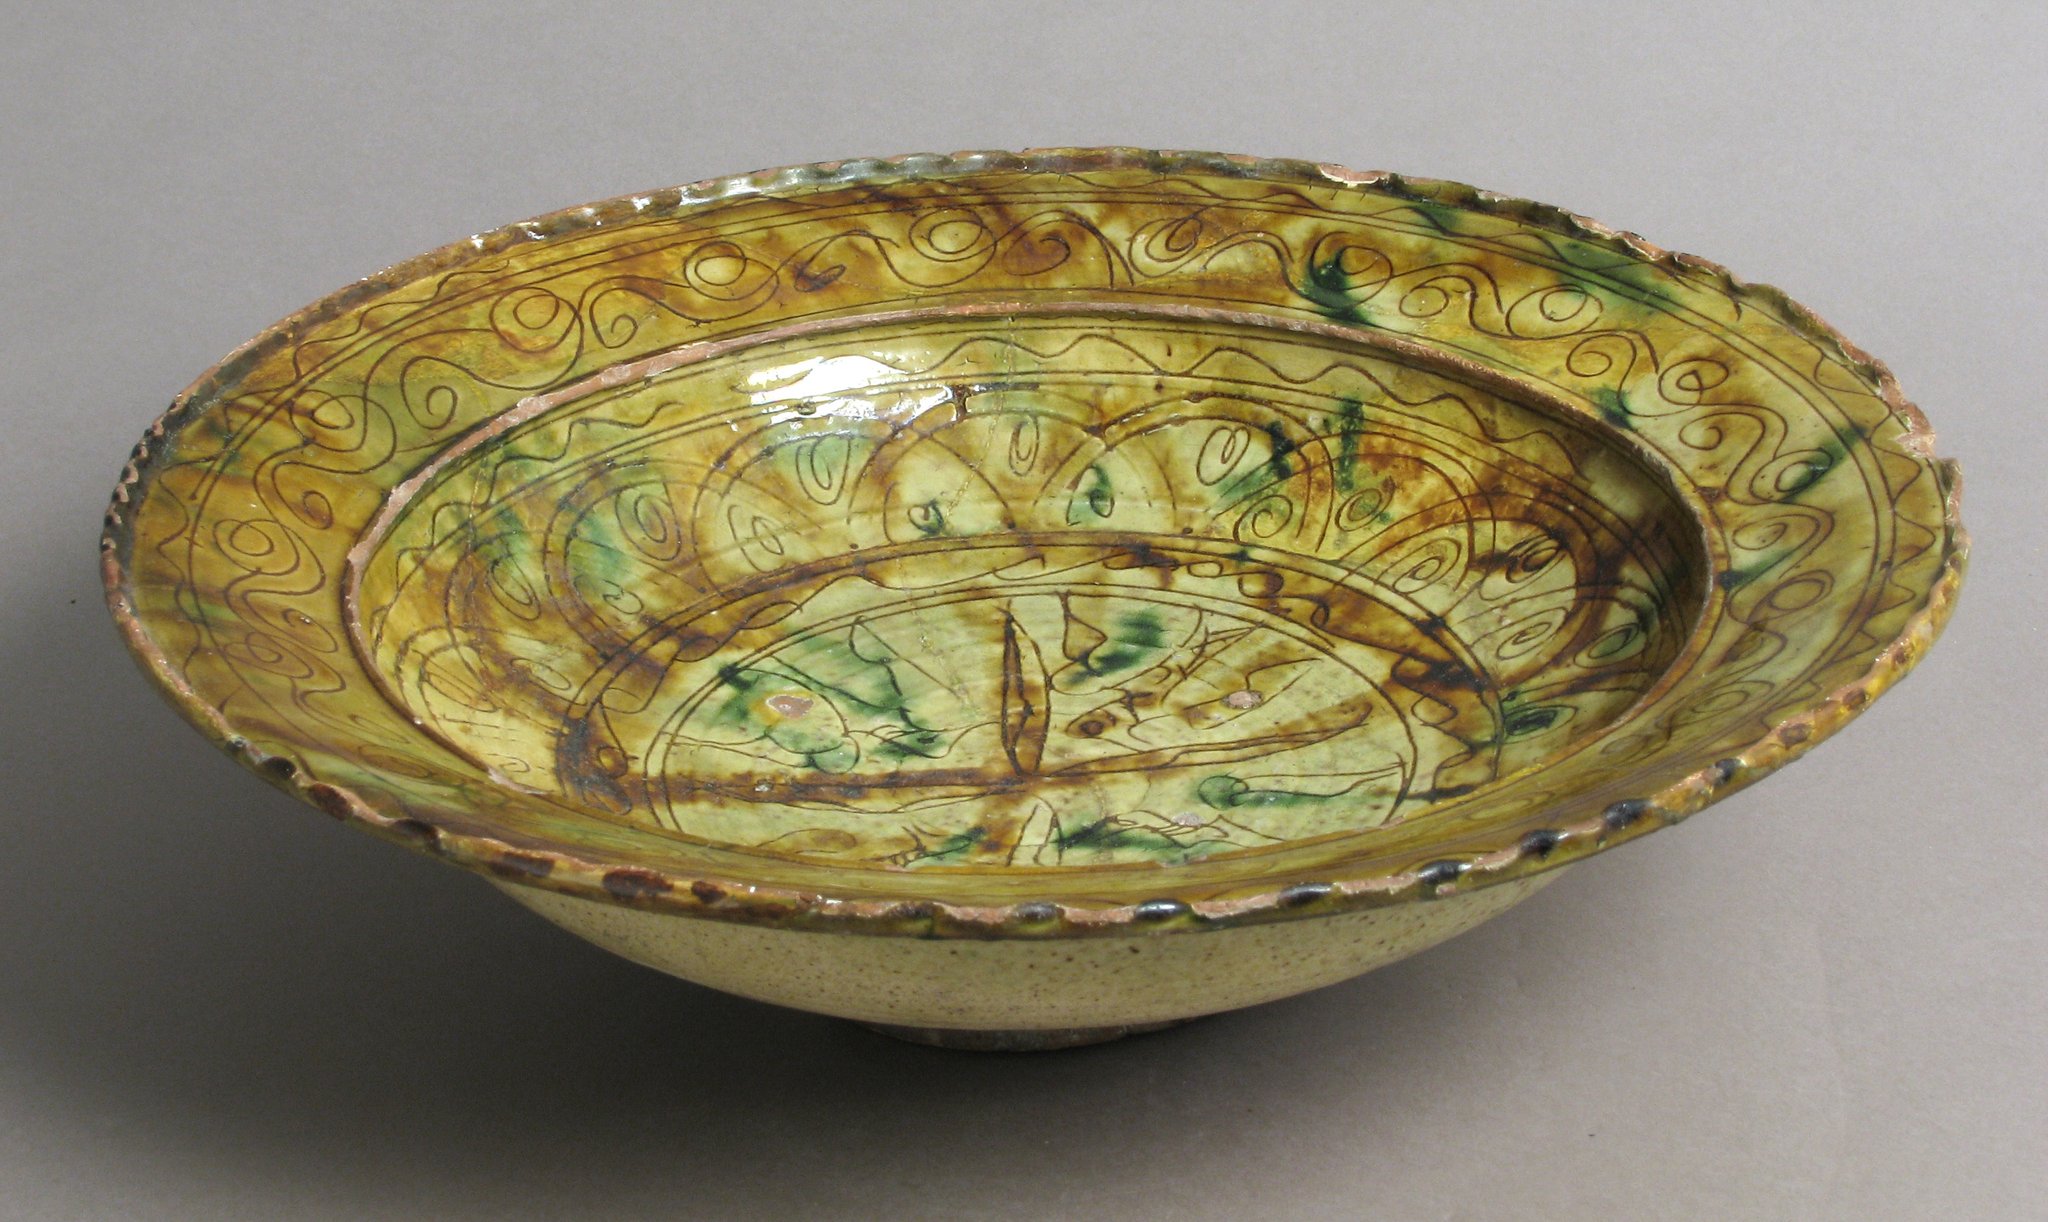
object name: bowl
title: Tricolor Bowl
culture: byzantine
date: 1301-1400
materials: glaze, terracotta